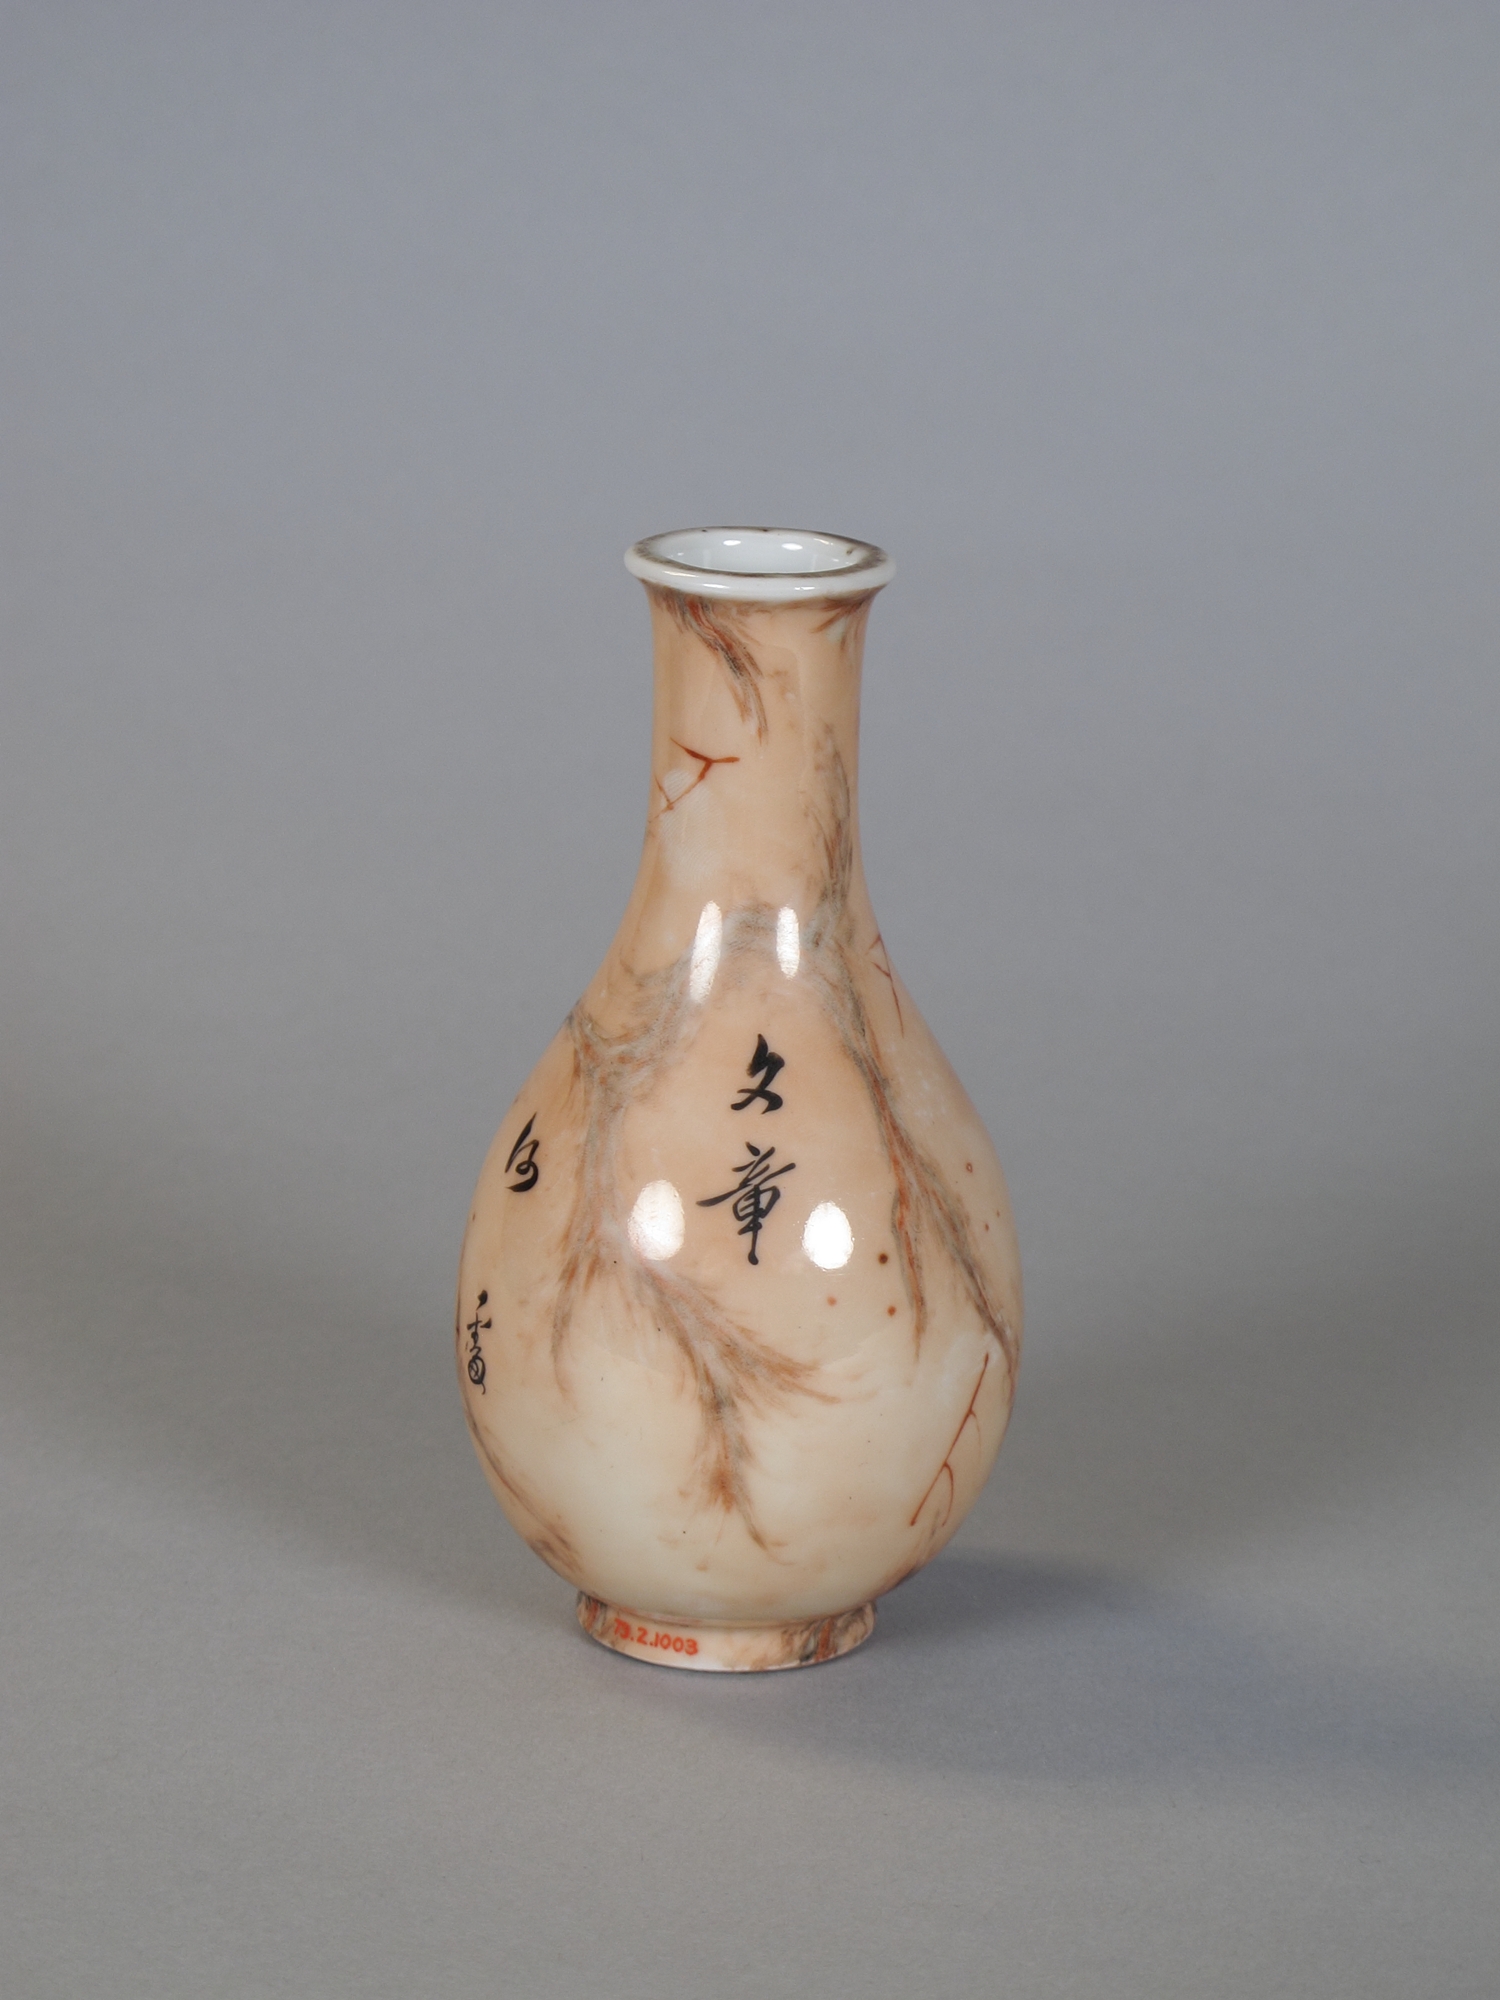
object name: vase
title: Vase with poem on marbled ground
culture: chinese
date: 1767-1800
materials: enamel, marble, porcelain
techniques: overglaze, painting, polychrome